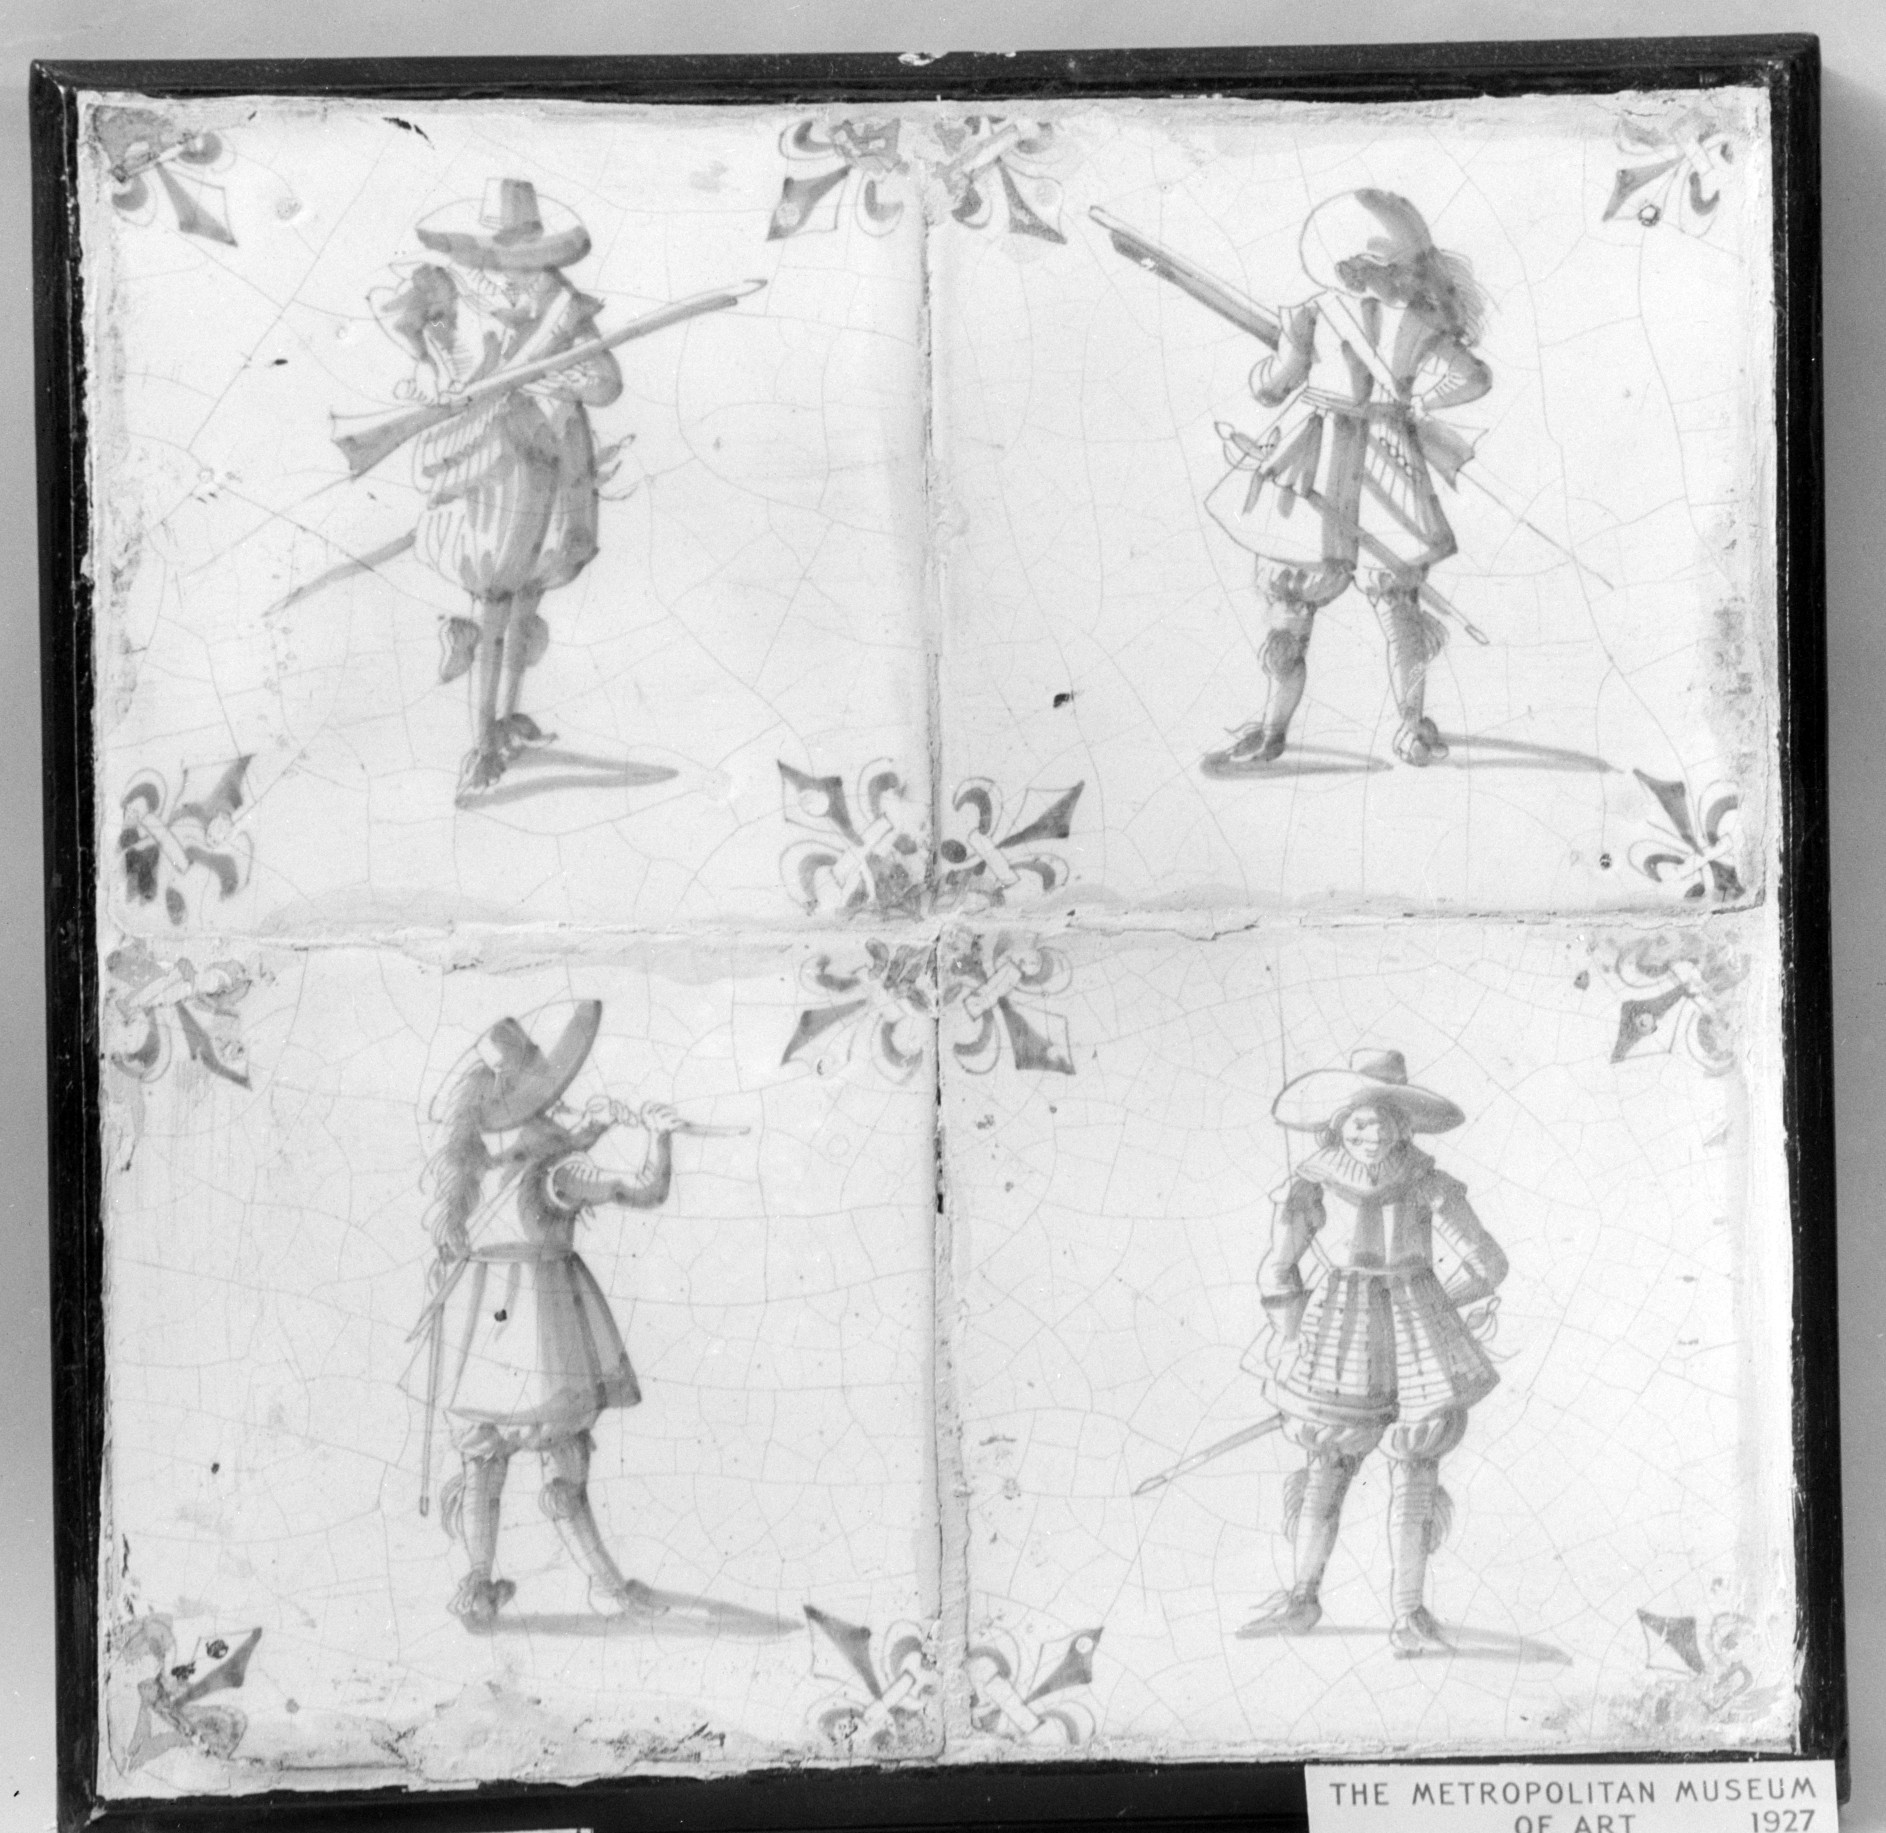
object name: tile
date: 1620-1650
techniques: glazing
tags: firearms,men